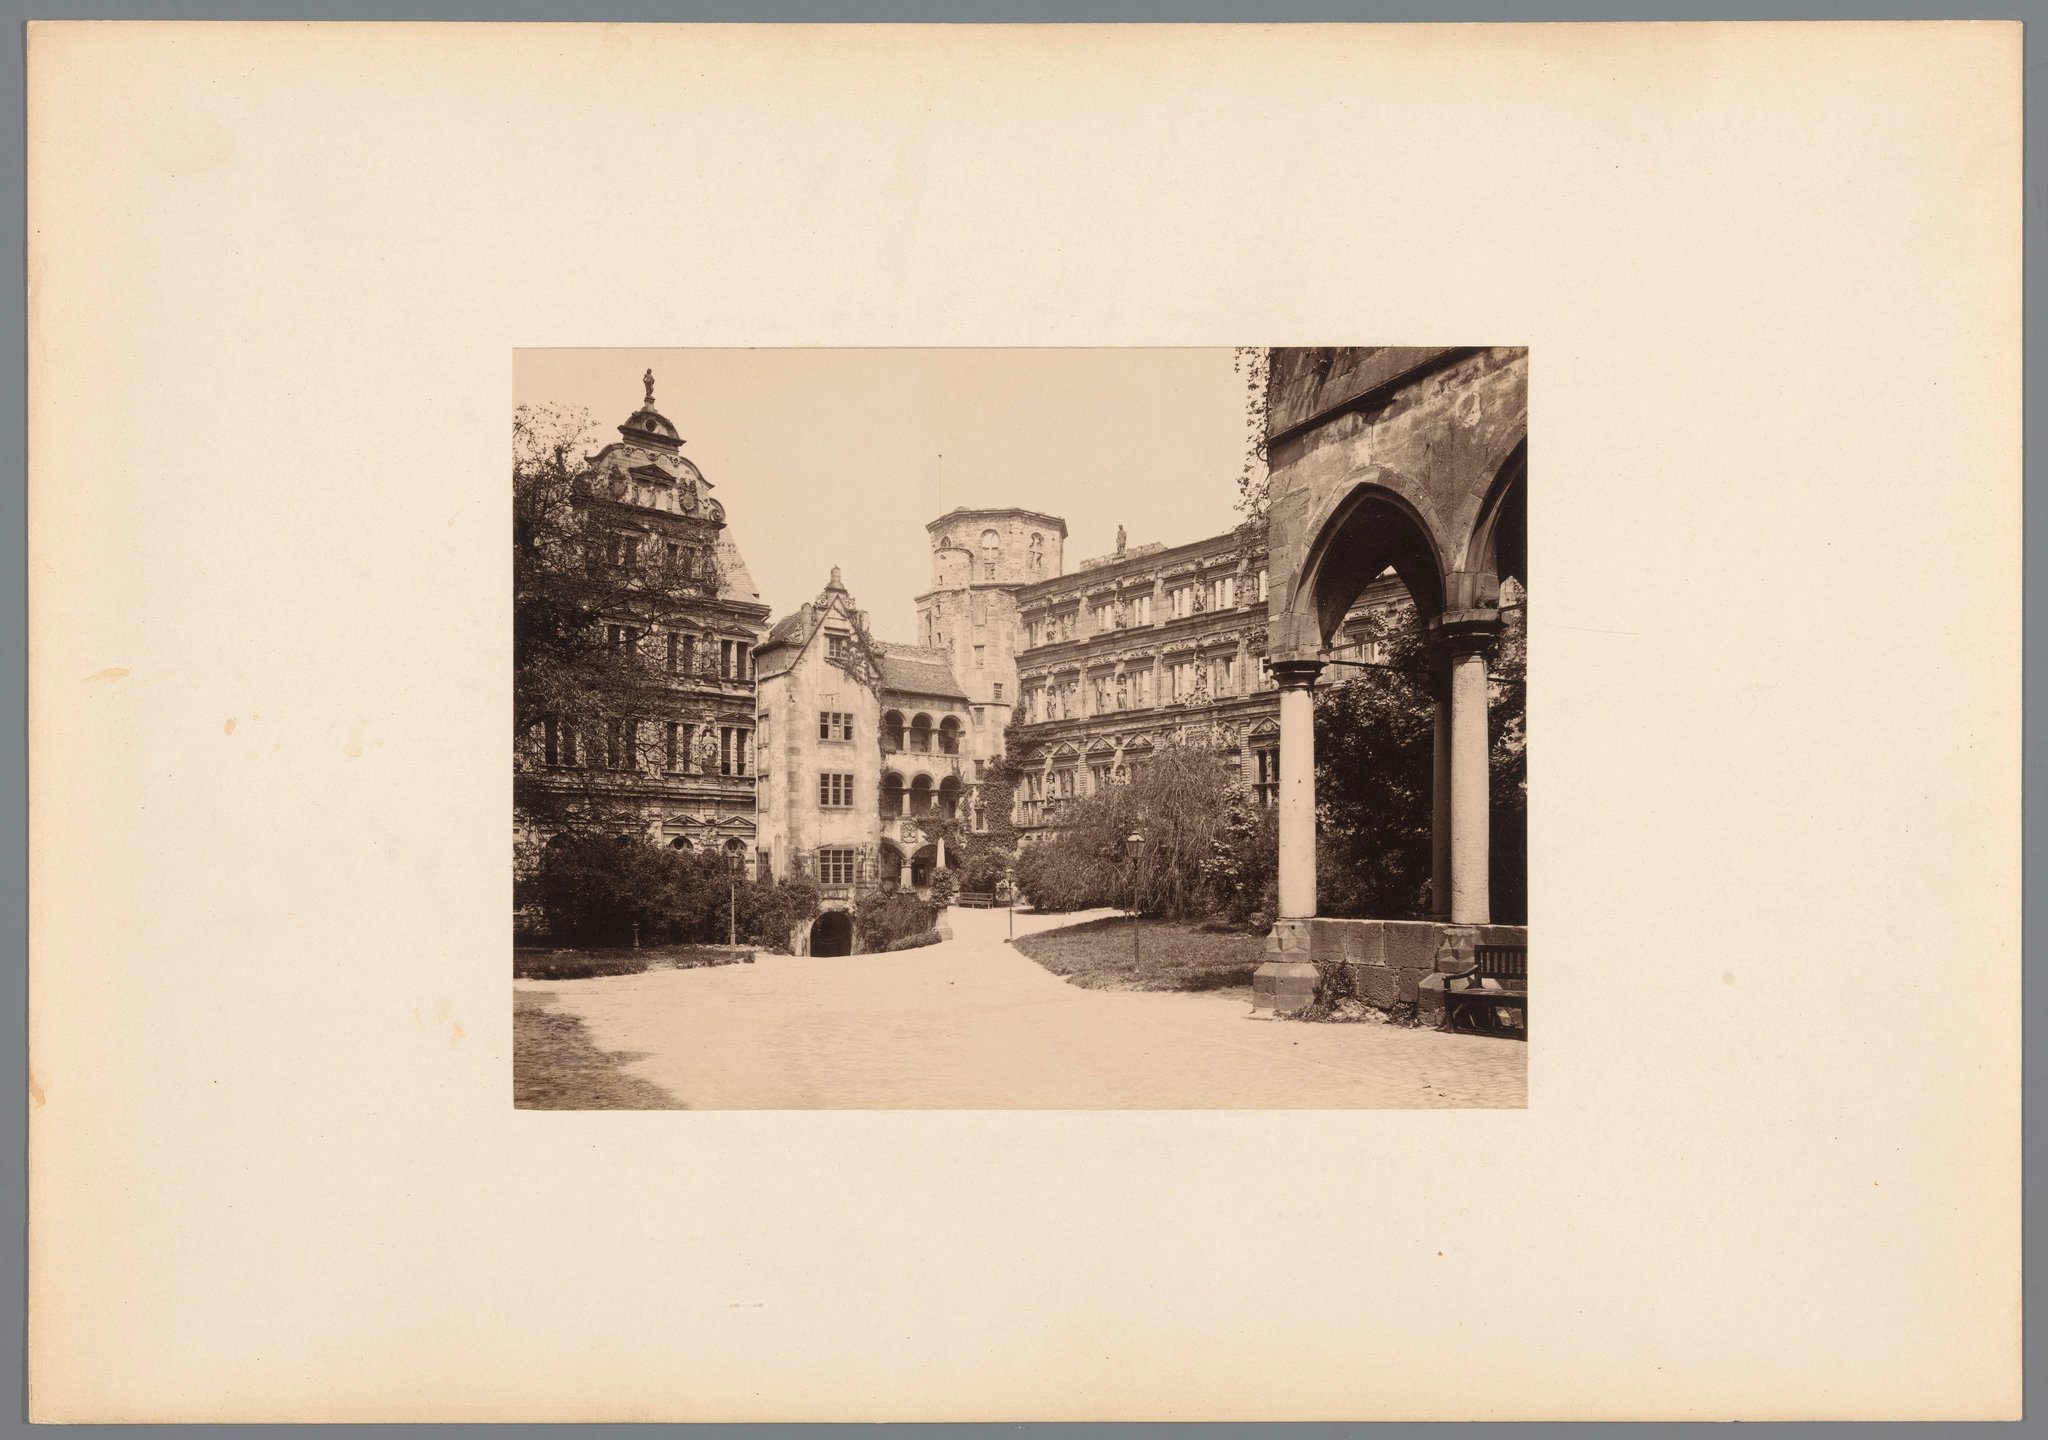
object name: photograph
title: Binnenplaats van het Schloss Heidelberg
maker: Anonymous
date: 1875-1900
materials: cardboard, photographic support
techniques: albumen print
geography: heidelberg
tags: colonnade, tower, clock tower ~ monumental adornment, castle, courtyard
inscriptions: collector's mark: ‘INSTITUUT VOOR KUNST-NIJVERHEIDSONDERWIJS GABRIËL METSUSTRAAT No. 16 AMSTERDAM’, collector's mark: ‘KUNSTNIJVERHEIDSCHOOL QUELLINUS AMSTERDAM FRANS HALSSTRAAT 14.’